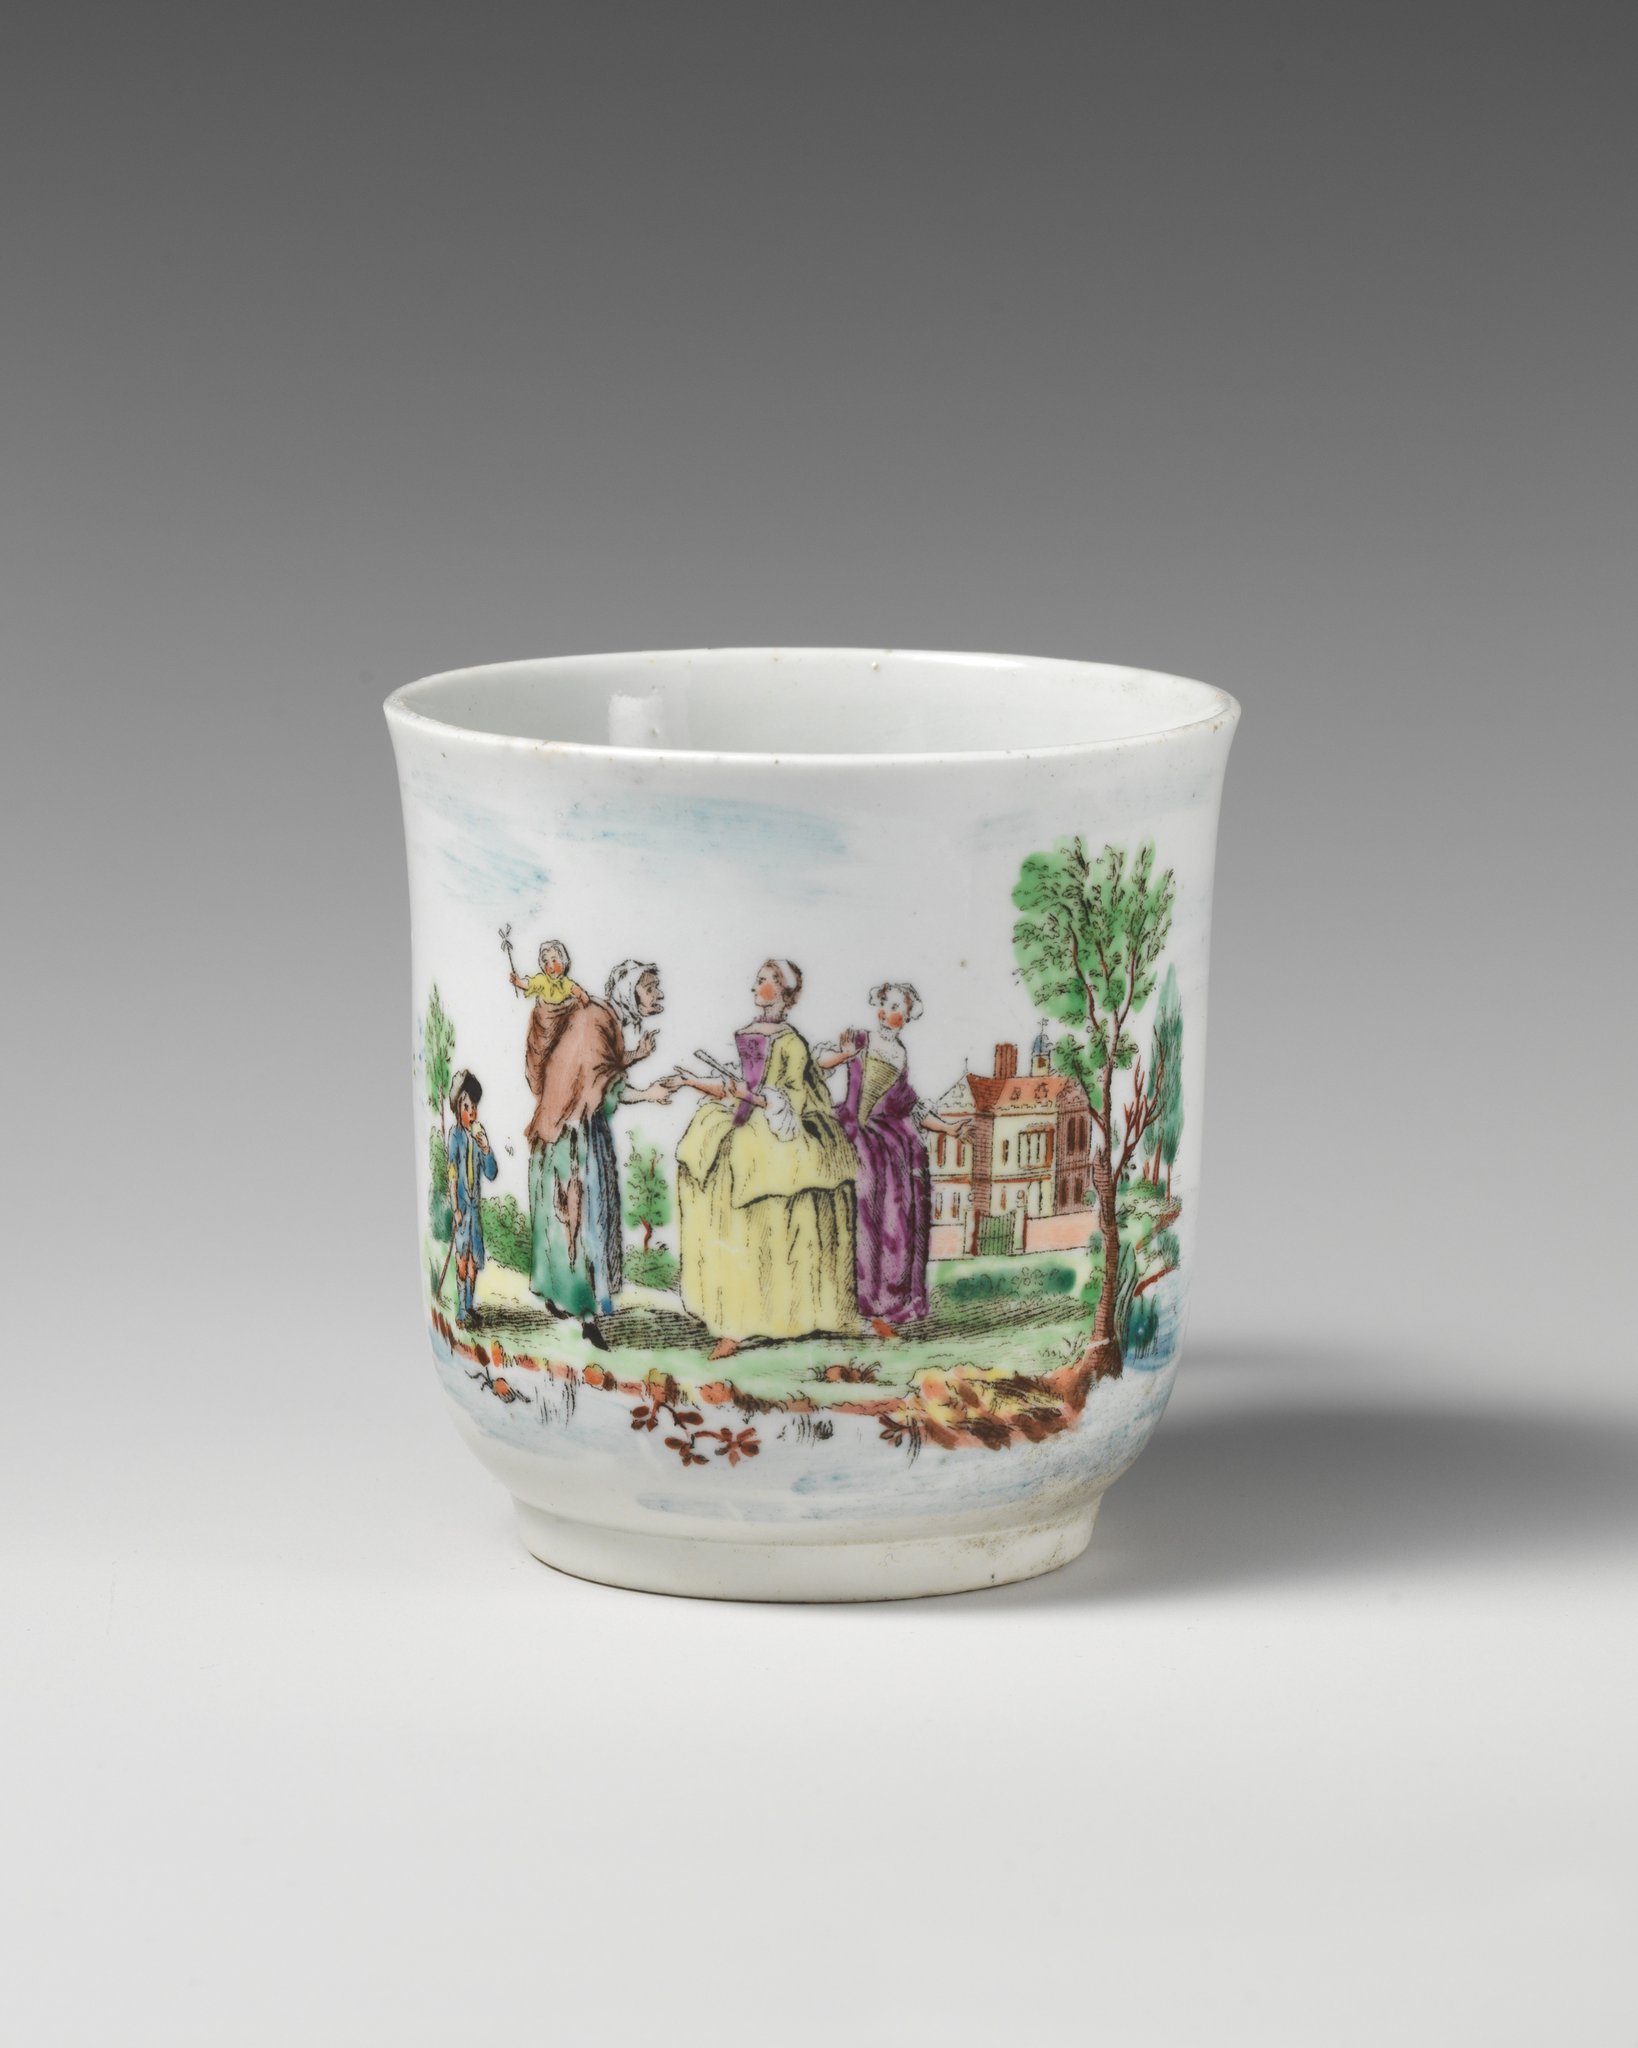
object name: cup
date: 1701-1800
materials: soft paste porcelain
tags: houses,infants,women